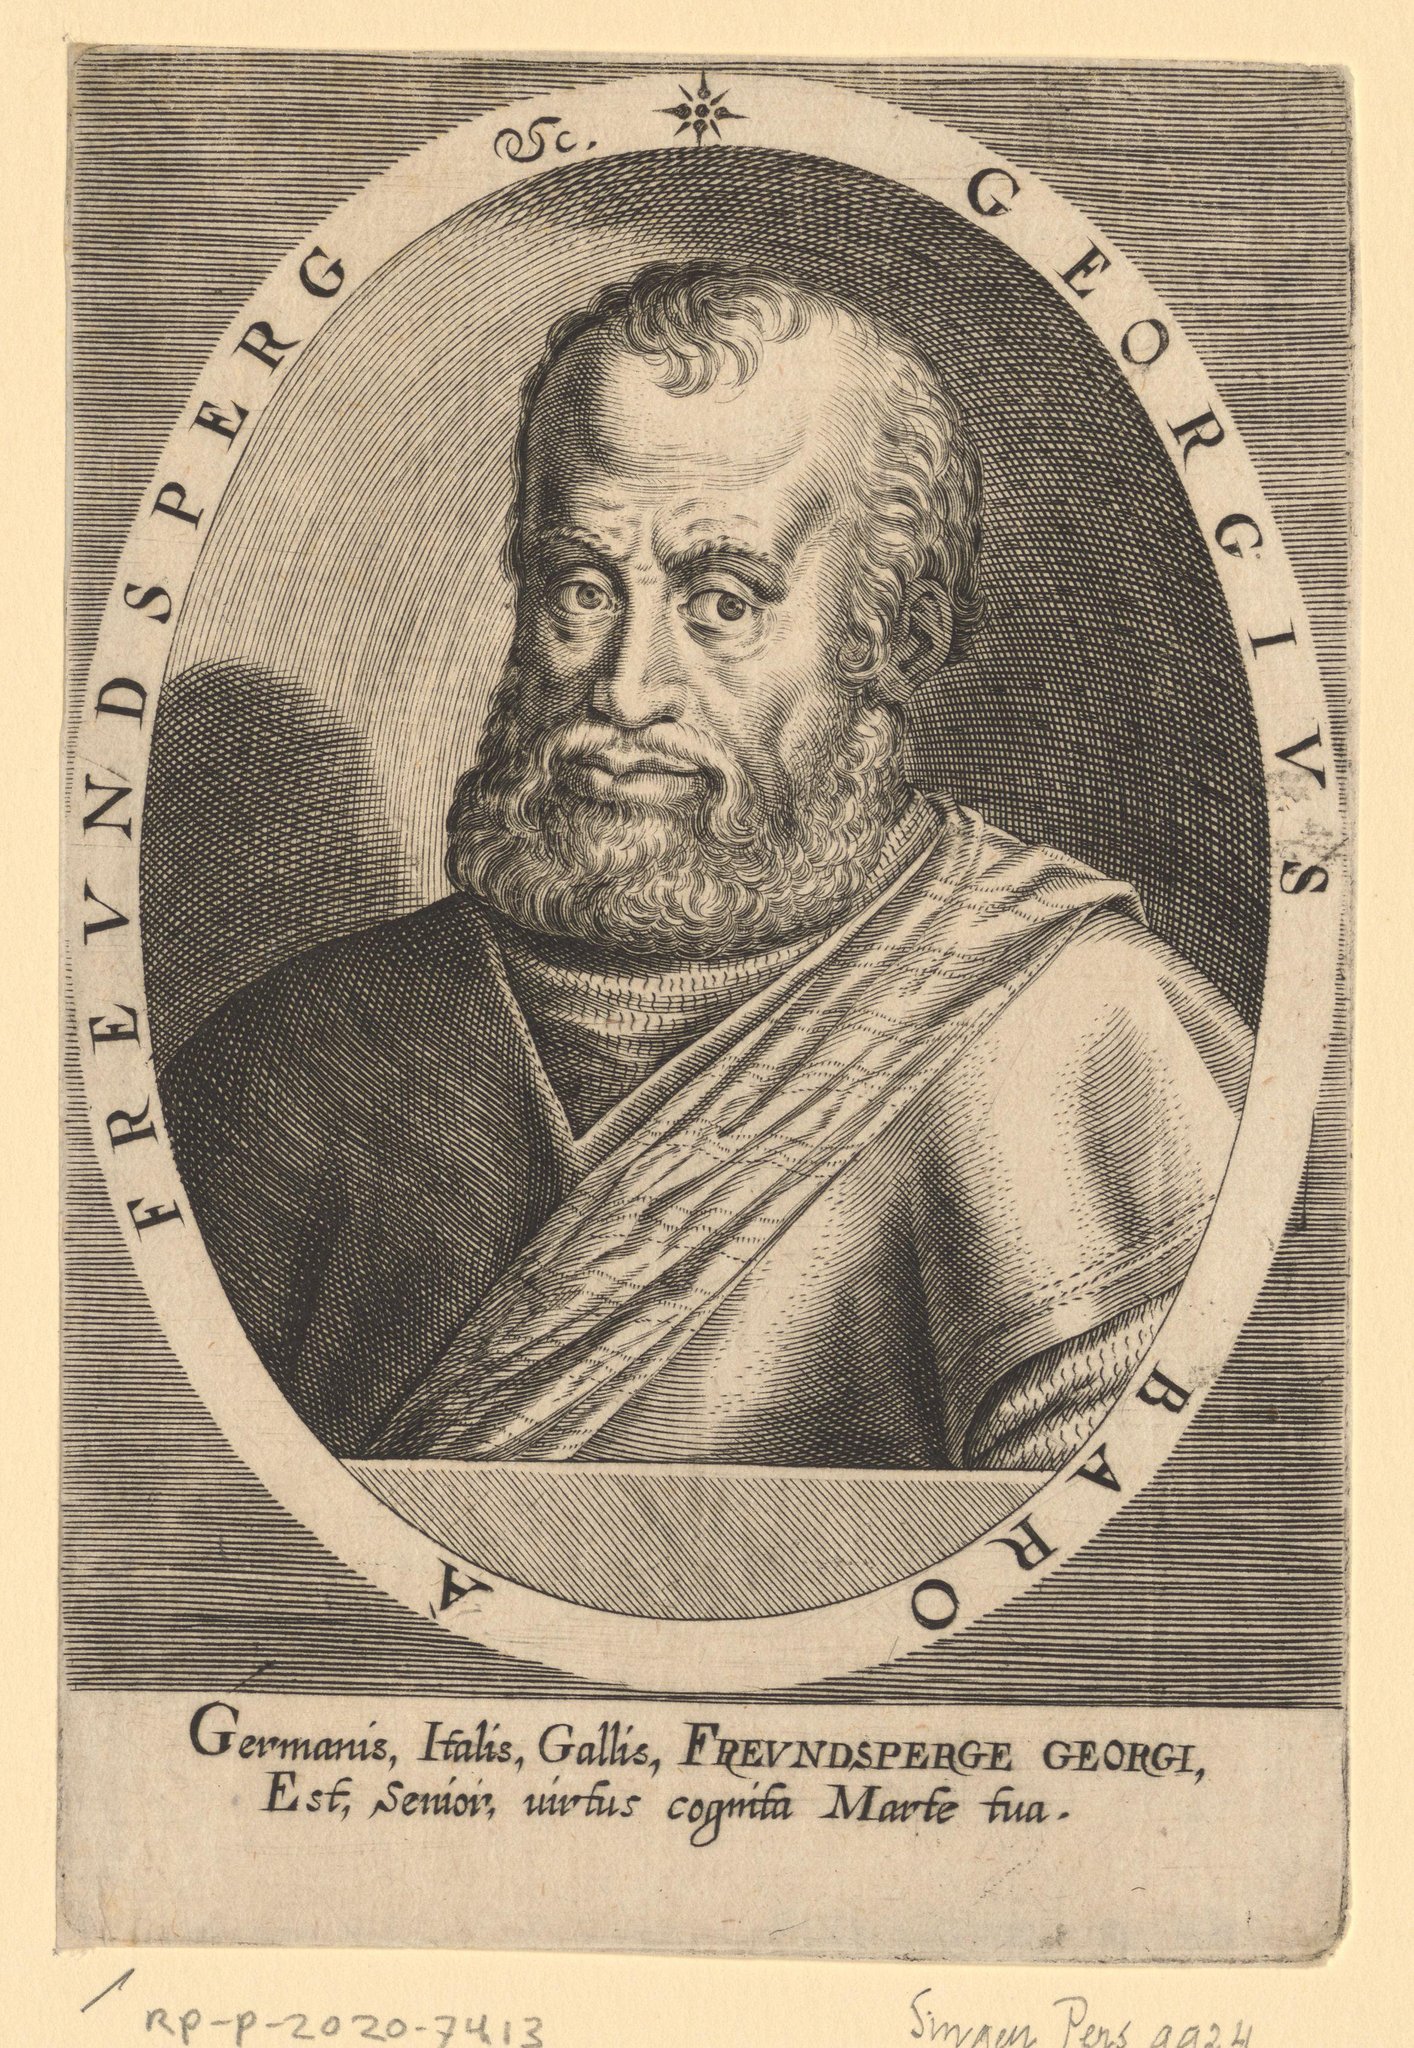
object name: print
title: Atrium Heroicum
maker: dominicus custos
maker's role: print maker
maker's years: 1560-1615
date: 1601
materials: paper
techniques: engraving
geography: augsburg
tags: commander-in-chief, general, marshal, historical persons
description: Prent waarschijnlijk uit: Custos, Dominicus. Atrium heroicum caesarum (...). Augsburg: Dominicus Custos, 1601, dl. 3. De serie werd in vier delen uitgegeven tussen 1600 en 1604.